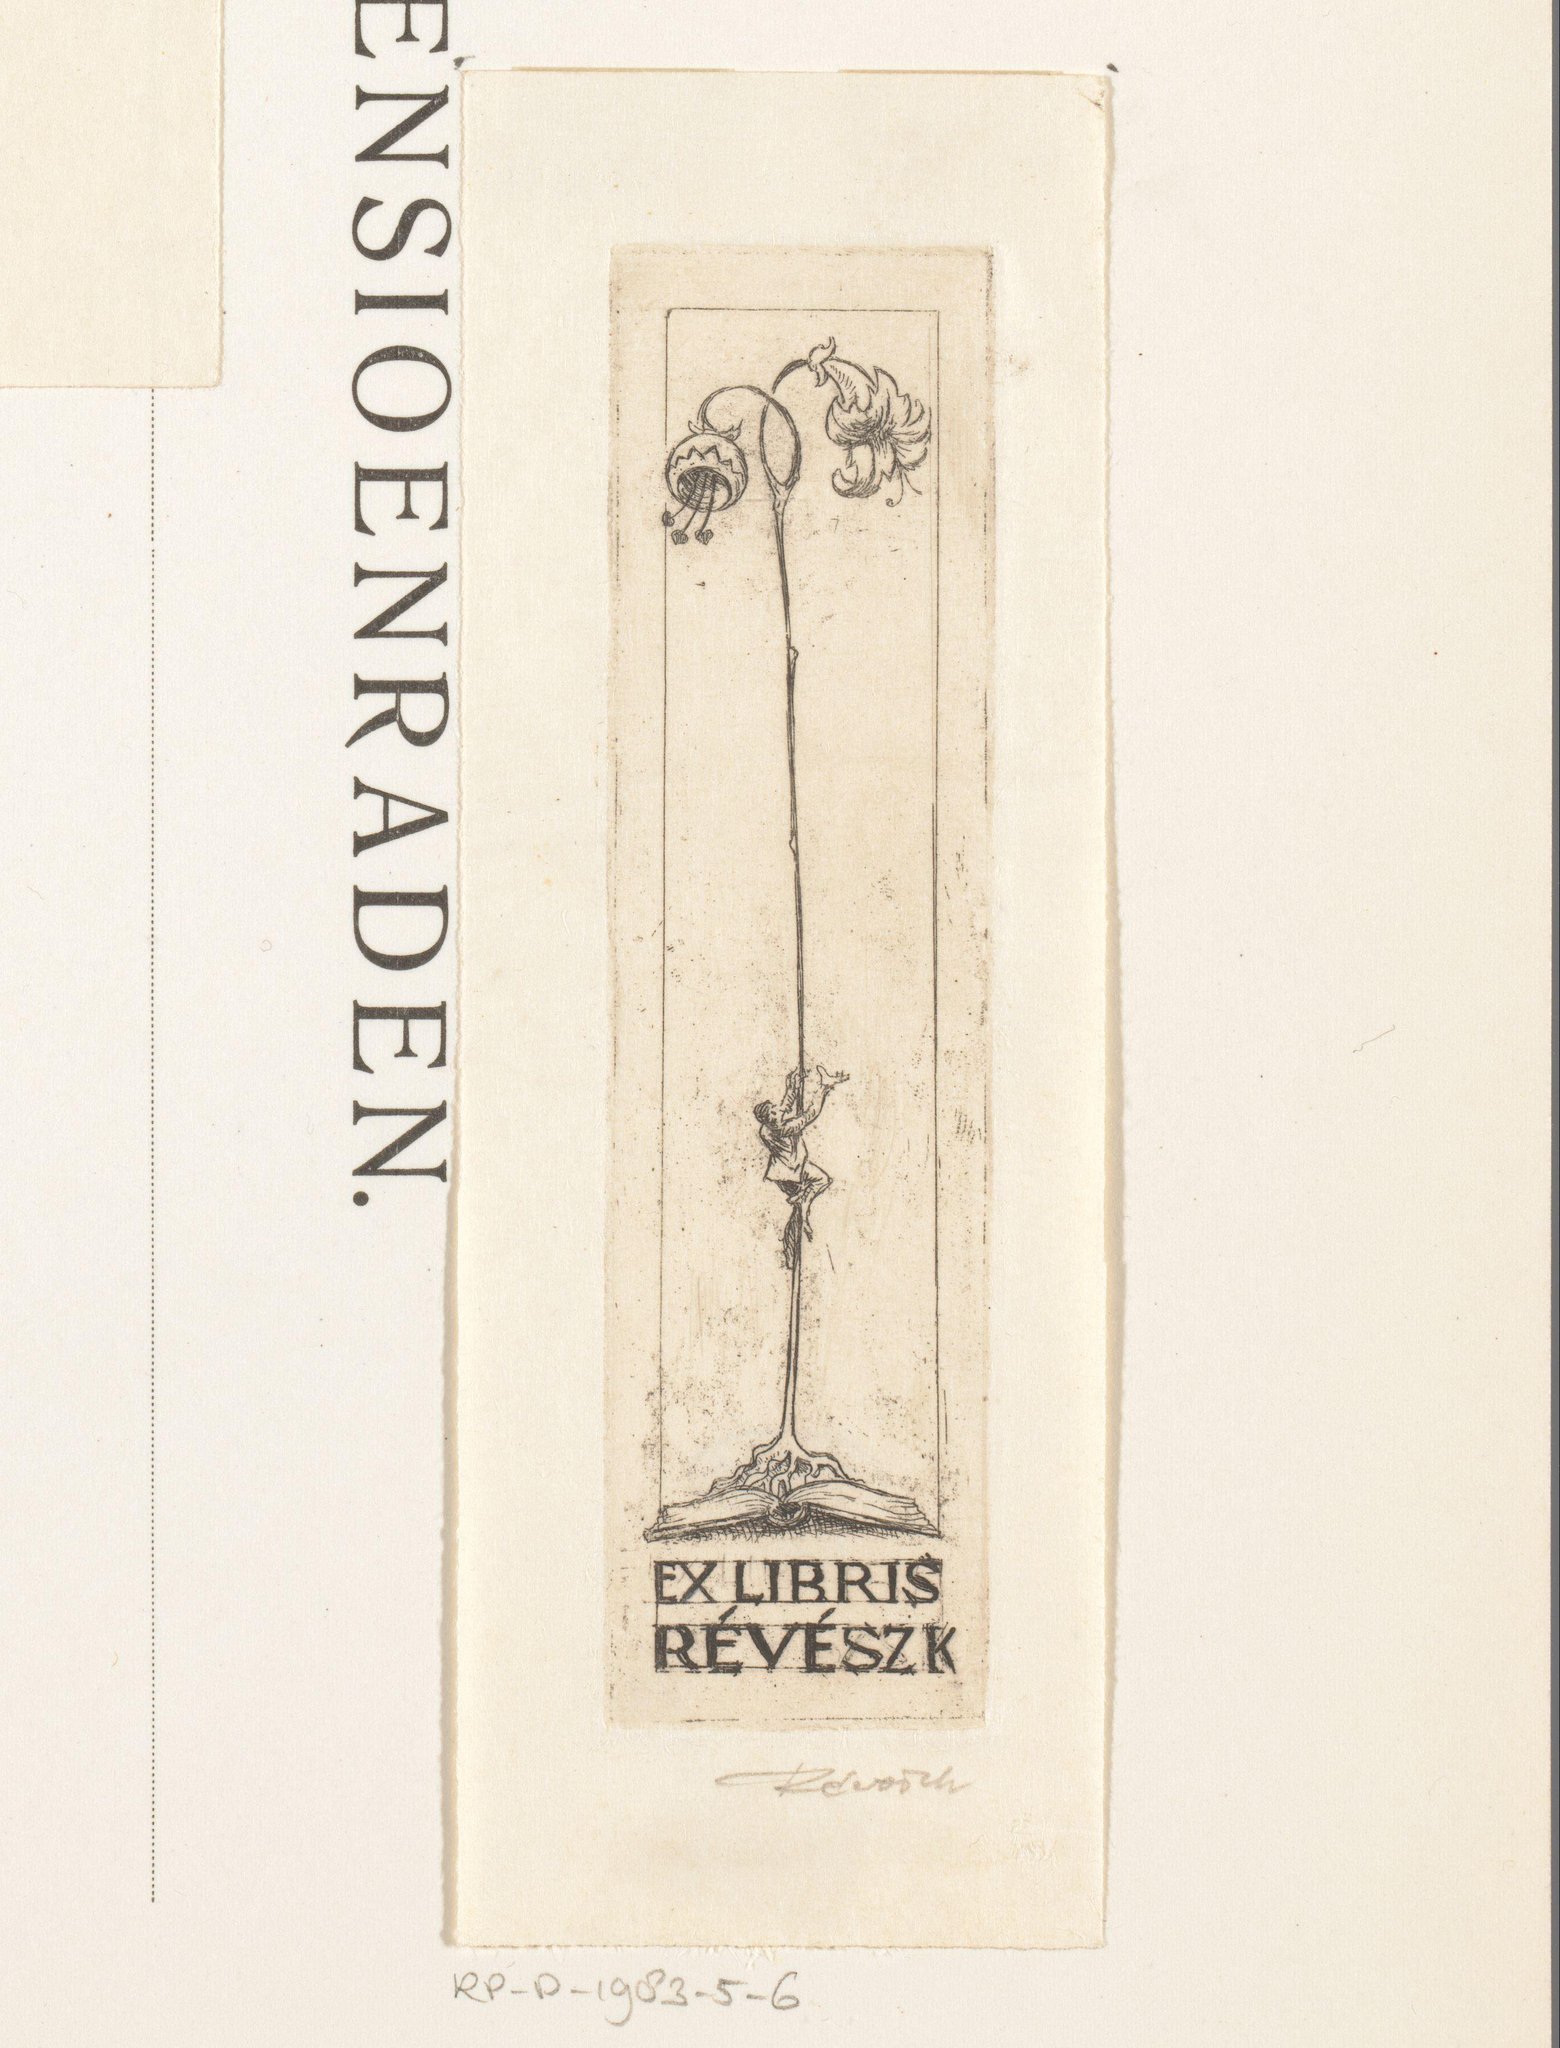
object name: bookplate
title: Ex libris Révész K.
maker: kornél révész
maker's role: print maker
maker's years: 1885-1944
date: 1932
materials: paper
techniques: etching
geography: budapest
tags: print maker, kornél révész, fantastic plants, fabulous vegetation, book, climbing up a tree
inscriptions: signature: ‘Révész’, date: ‘No. 62/ 1932’, workshop stamp: ‘Fecit/ Révész Kornél/ Budapest’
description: Ex libris maakt deel uit van omslag met 64 ex libris op 34 losse opzetvellen, een catalogus en een tekstblad.